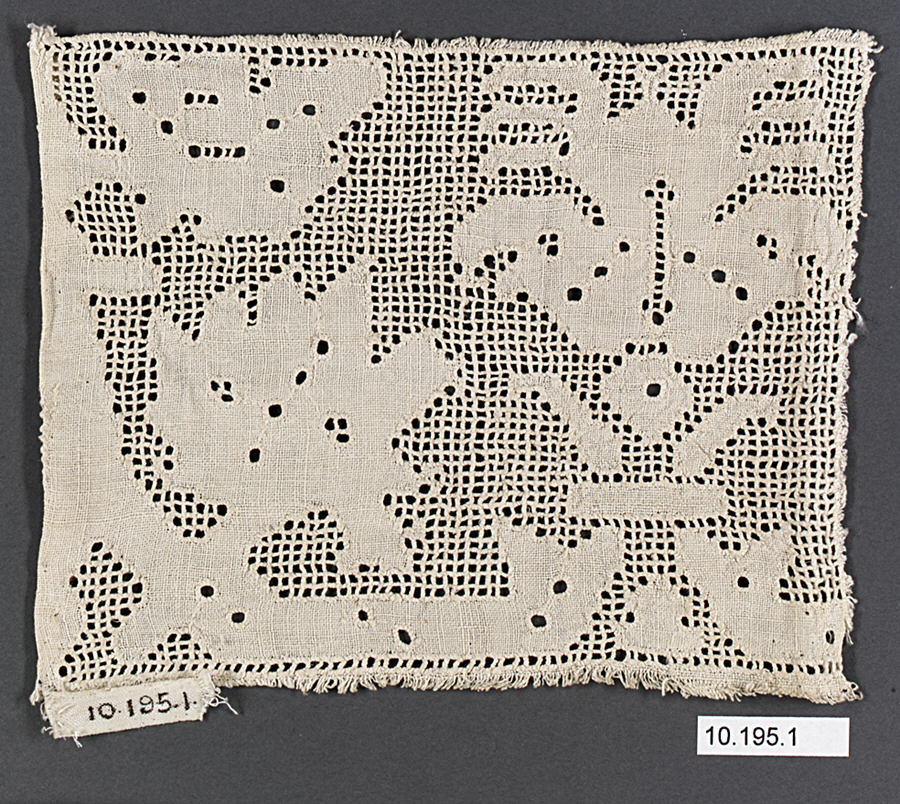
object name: drawnwork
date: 1601-1700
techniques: embroidery